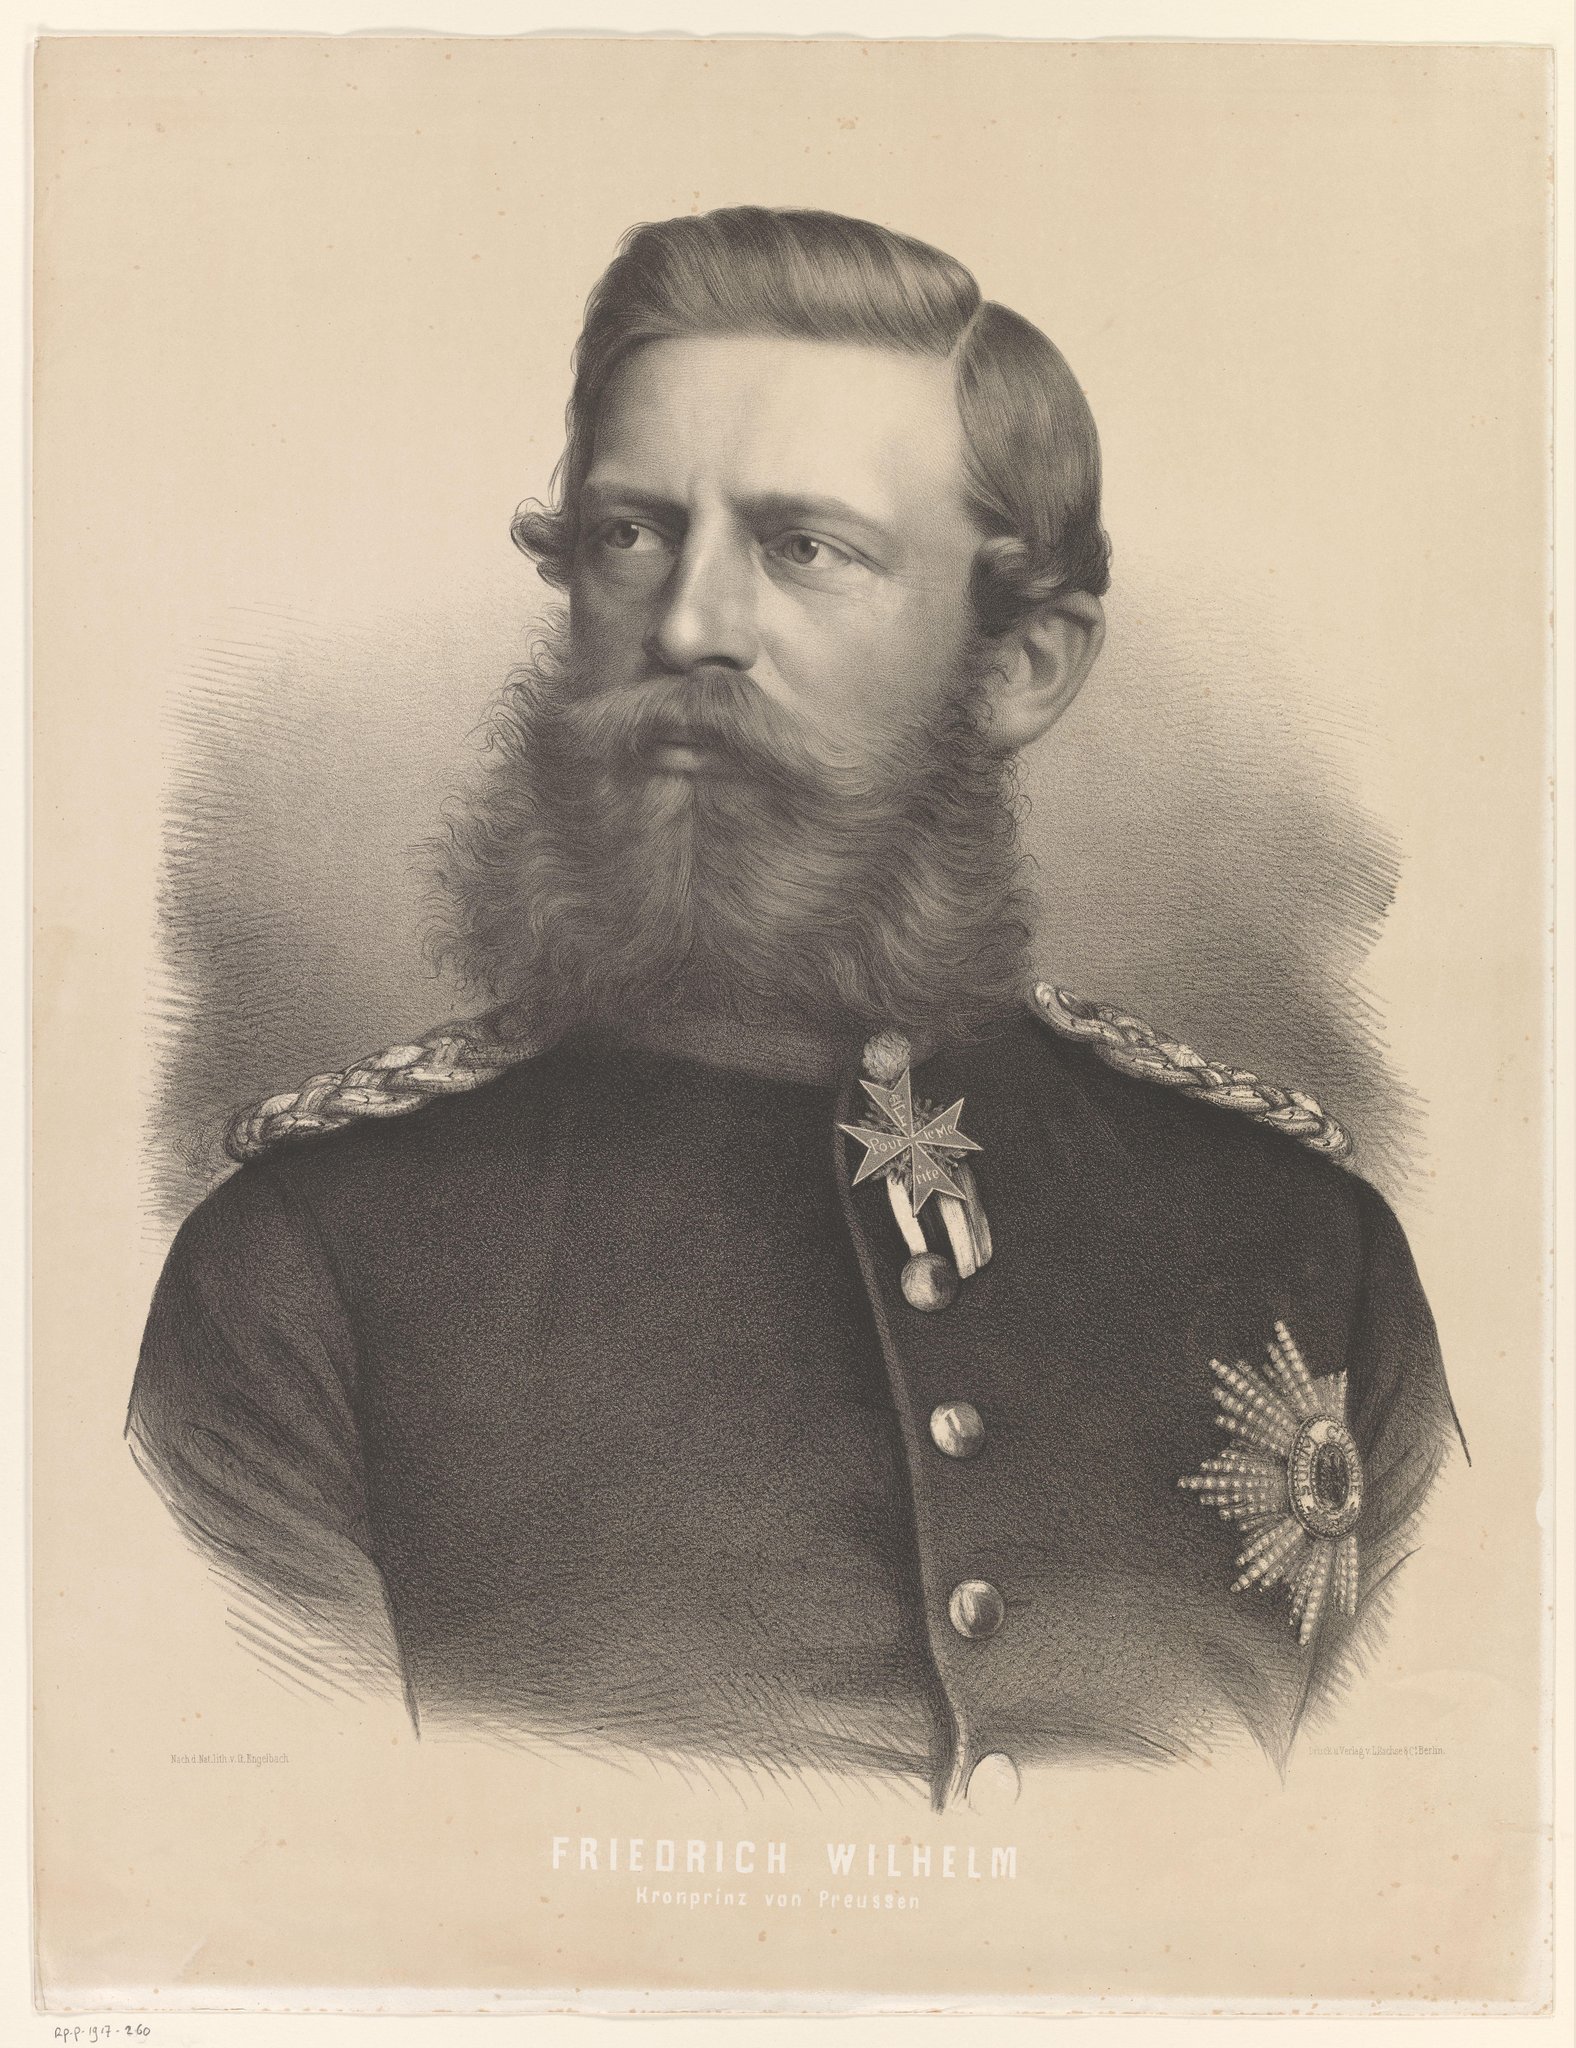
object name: print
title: Portret van kroonprins Frederik van Pruisen, de latere Frederik III, koning van Pruisen en Duits keizer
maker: georg engelbach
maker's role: print maker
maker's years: 1817-1890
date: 1861-1888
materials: paper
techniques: tone lithography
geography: berlin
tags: adult man, historical persons, beard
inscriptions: collector's mark: Lugt 2228